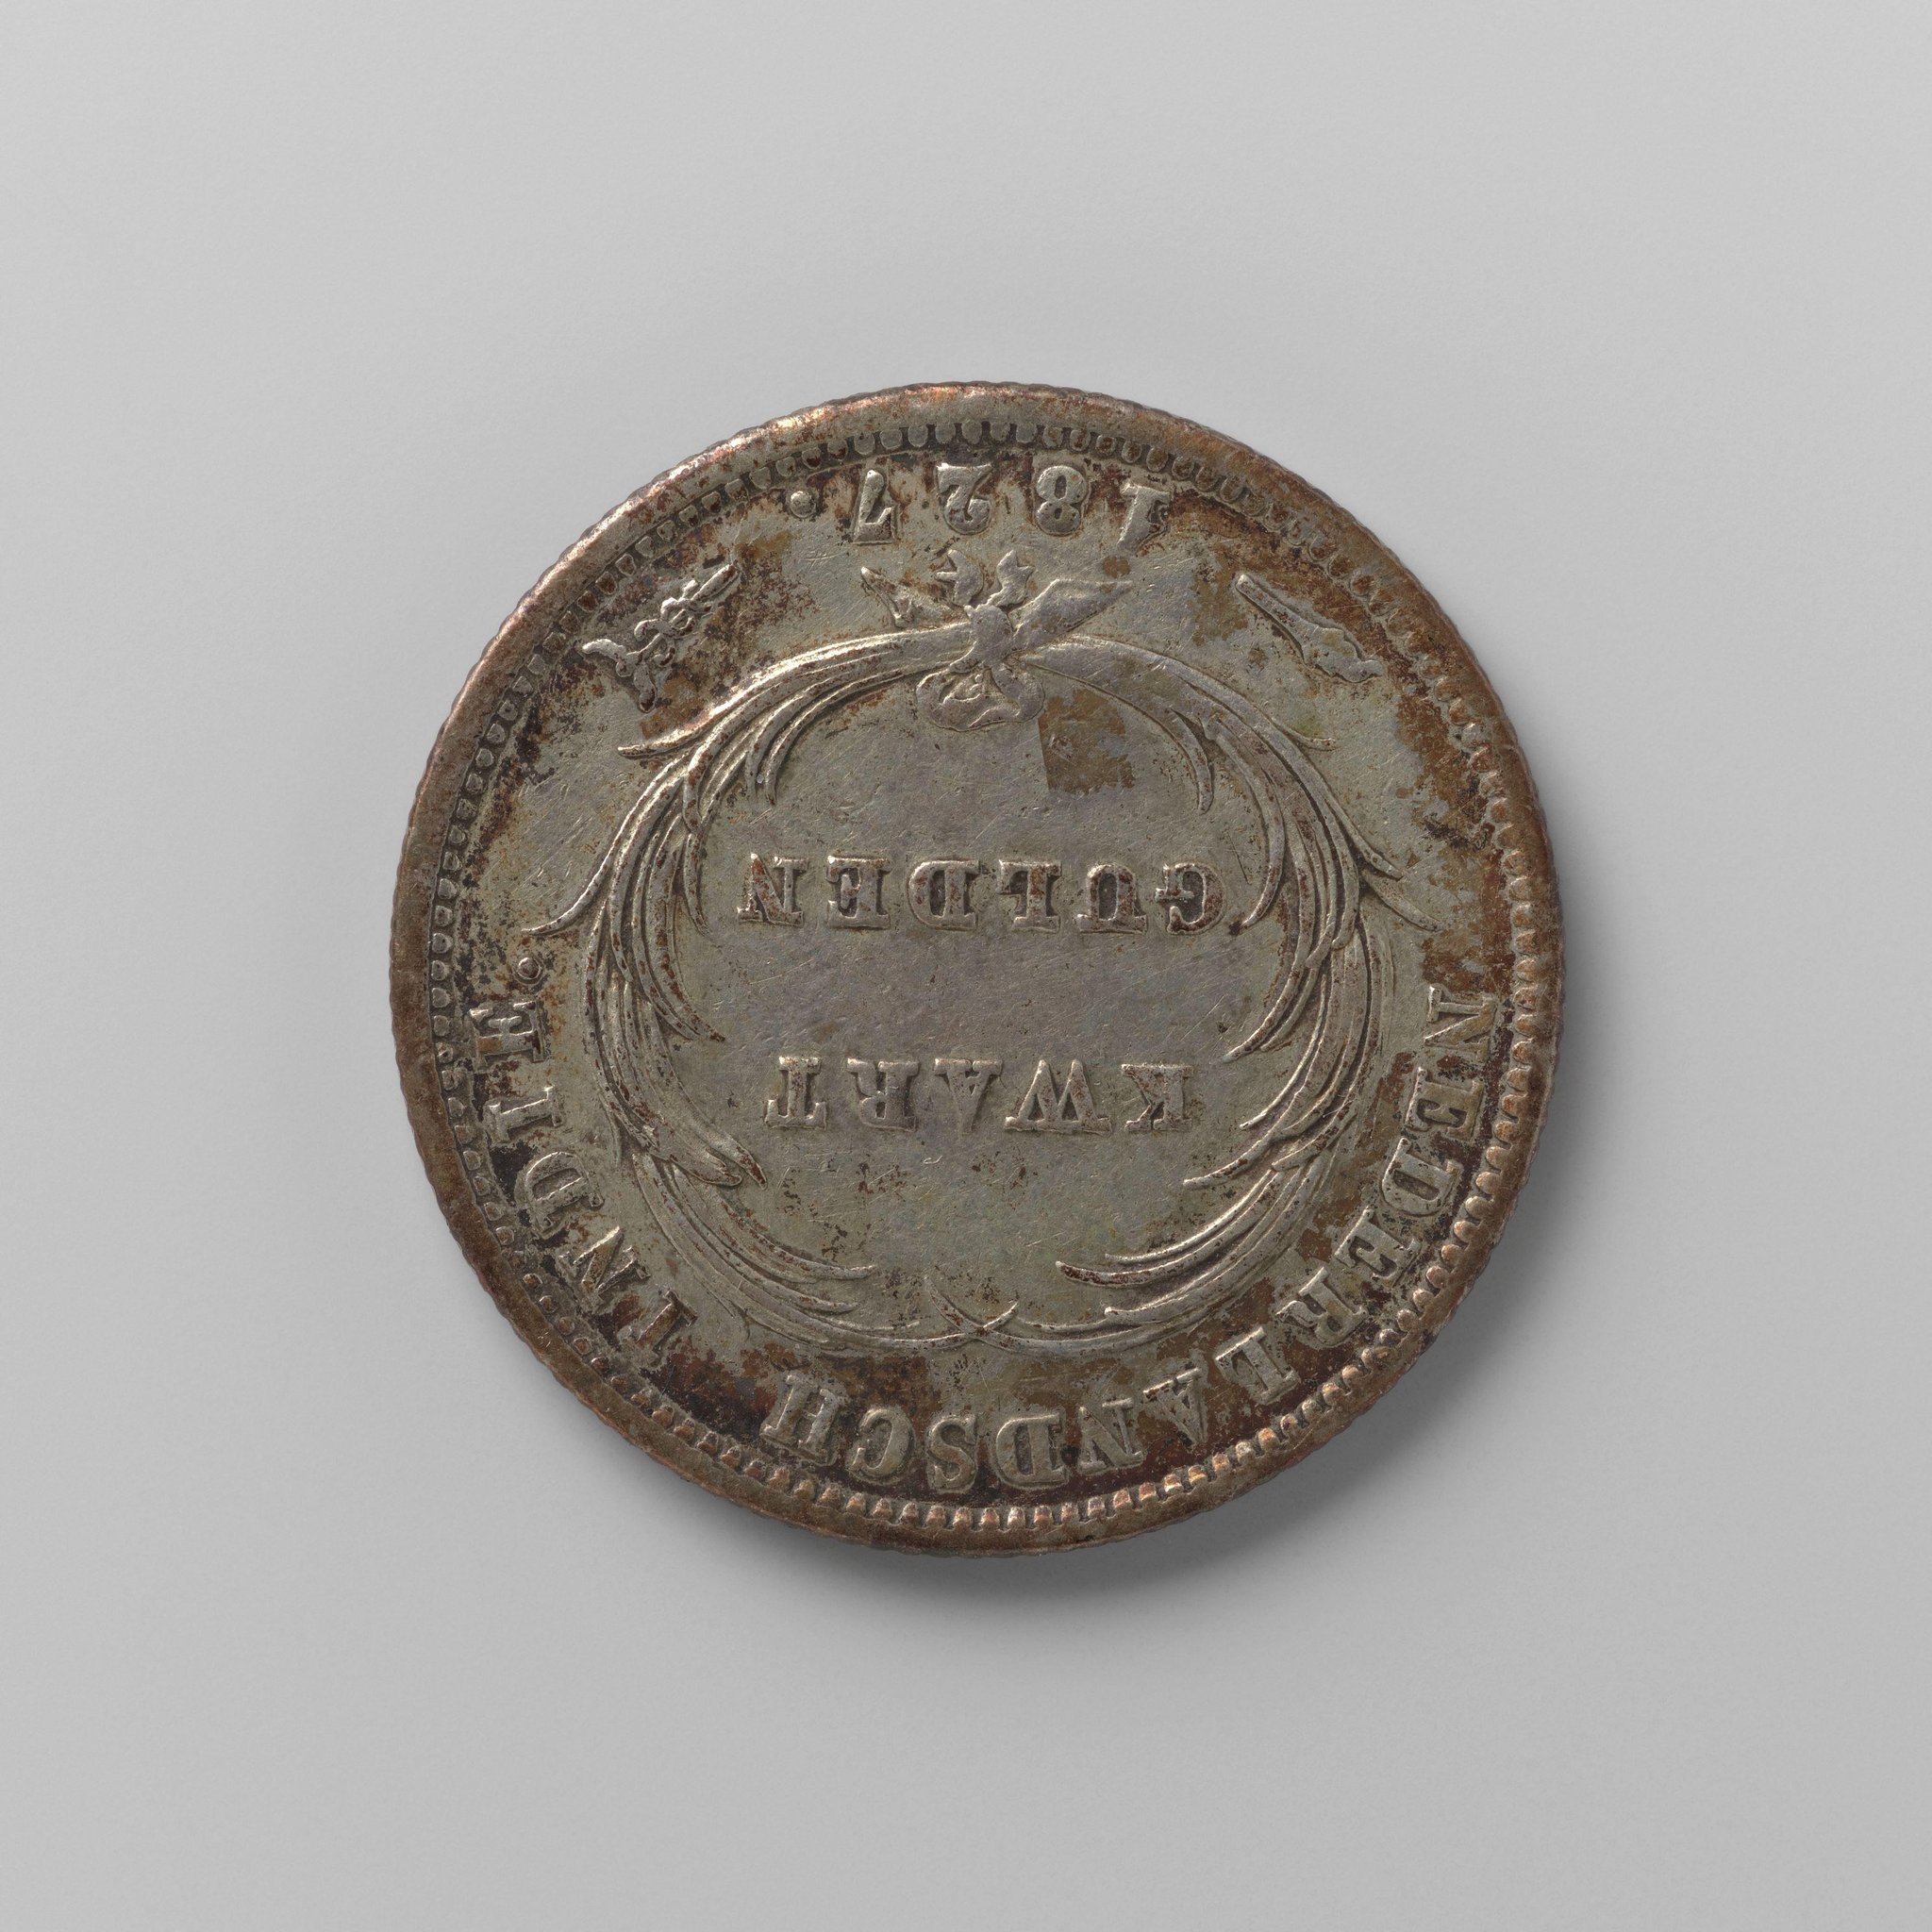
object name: coin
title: Nederlands Indië, 1/4 gulden, 1827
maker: william i of the netherlands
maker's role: koning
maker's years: 1772-1843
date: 1827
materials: silver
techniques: striking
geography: utrecht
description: Zilveren munt. Voorzijde: borstbeeld naar rechts. Keerzijde: tussen twee samengebonden palmtakken waarde-aanduiding. Jaartal onderaan. Kartelrand